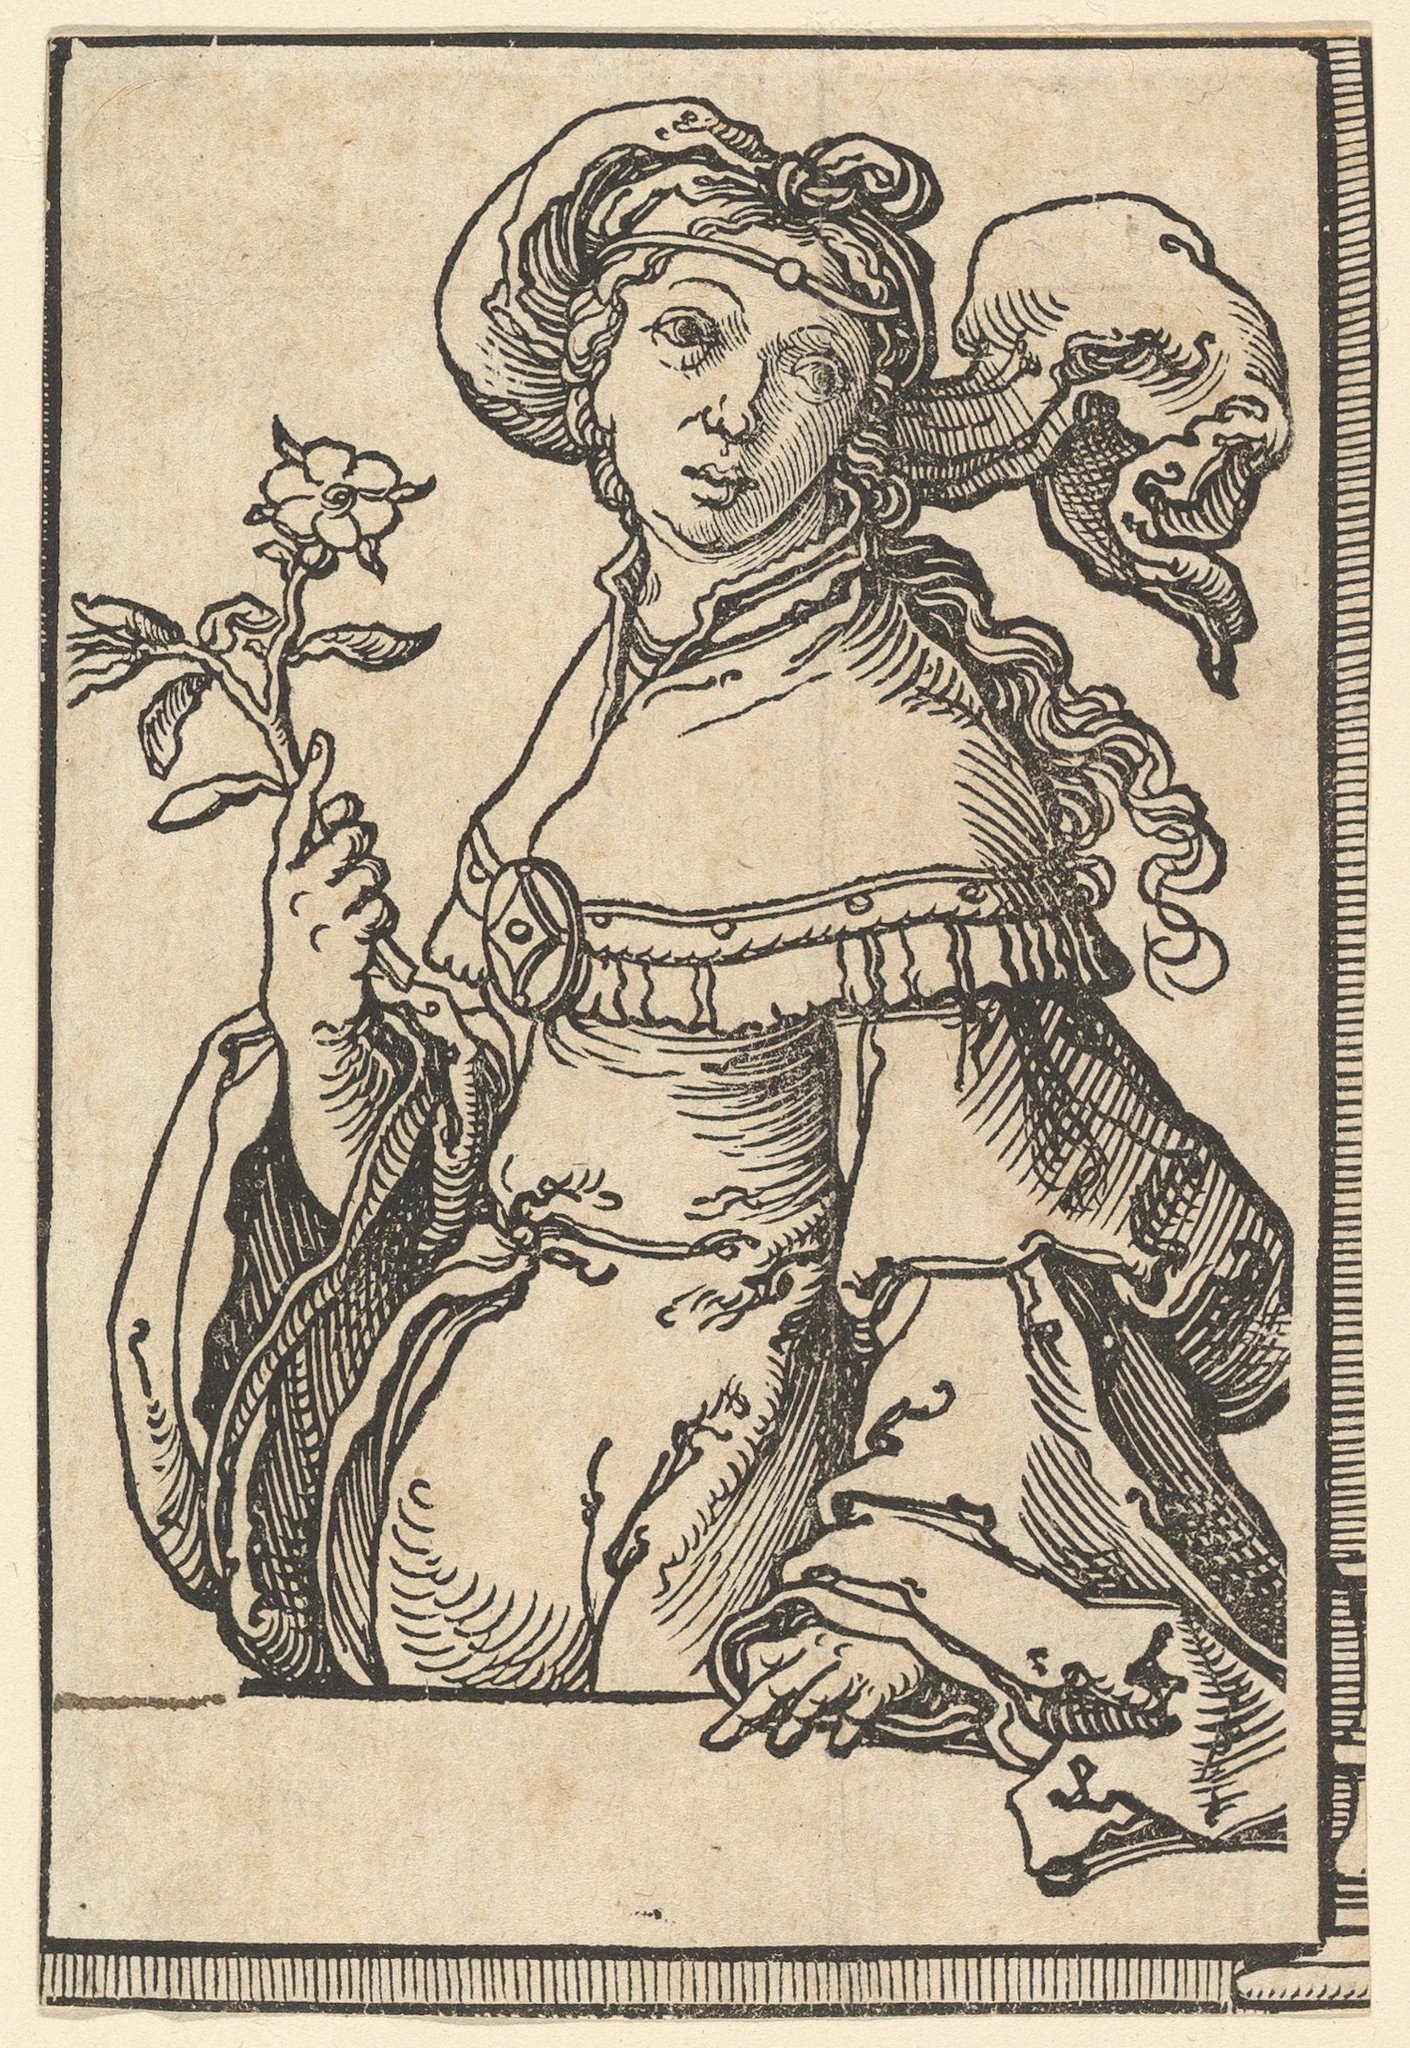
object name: print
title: Erythrean Sibyl, from the series of Sibyls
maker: lucas van leyden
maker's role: artist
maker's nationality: netherlandish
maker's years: 1494-1533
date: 1530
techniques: woodcut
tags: portraits,sibyl